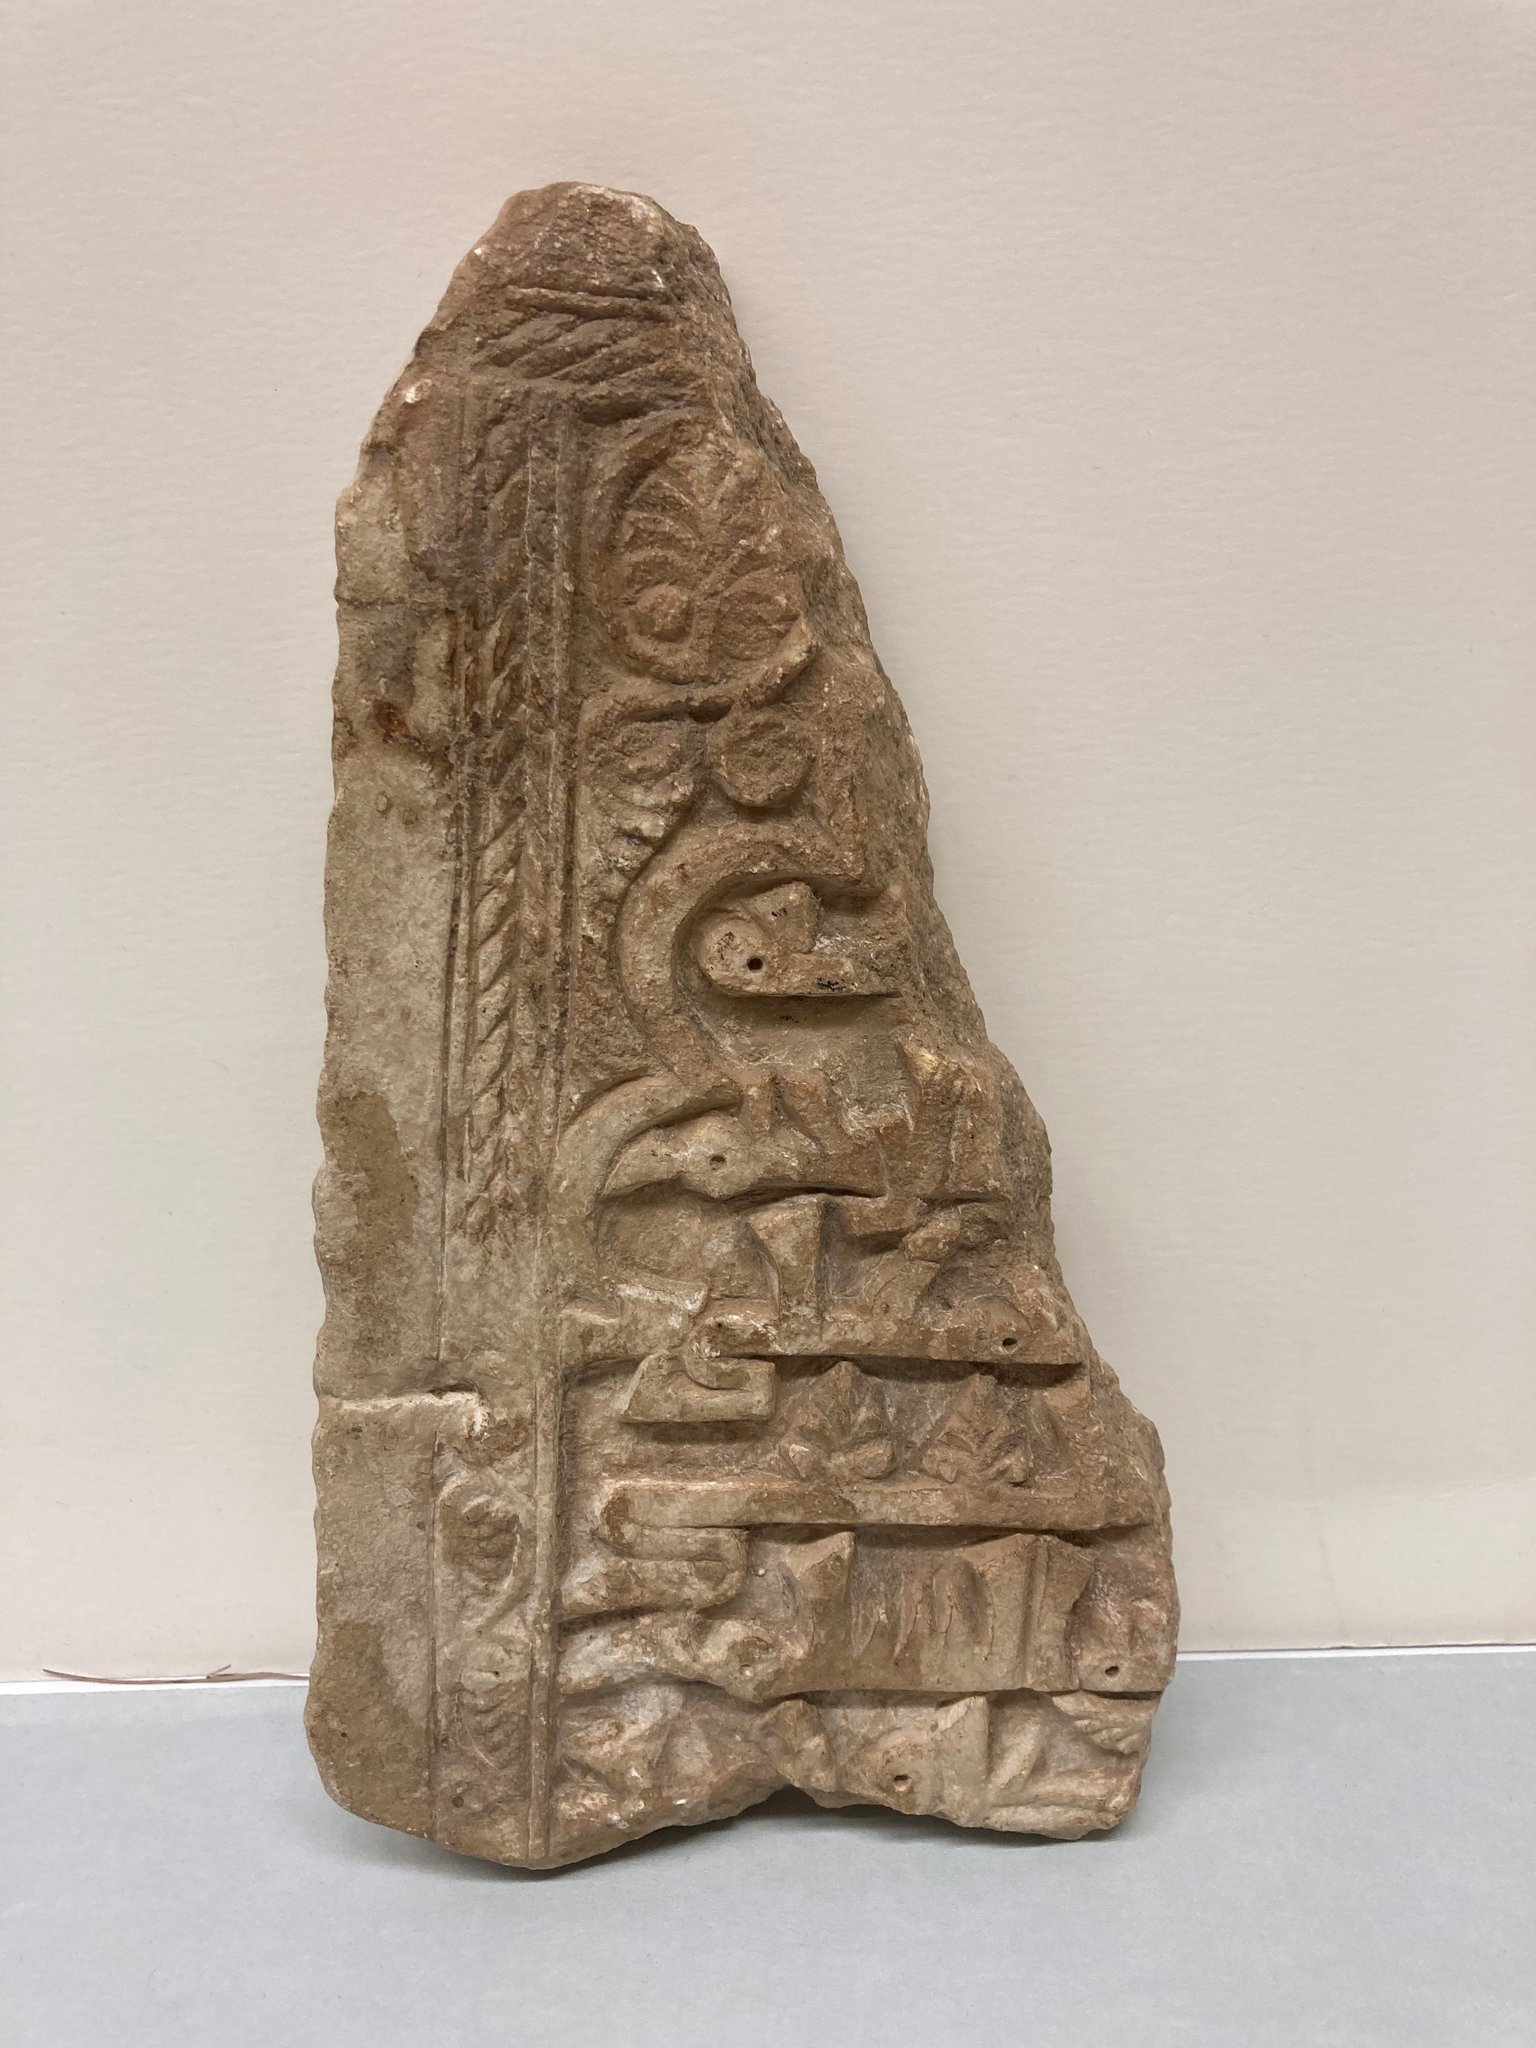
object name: tombstone fragment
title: Fragment of Tombstone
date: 801-1000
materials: limestone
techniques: carving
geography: iran